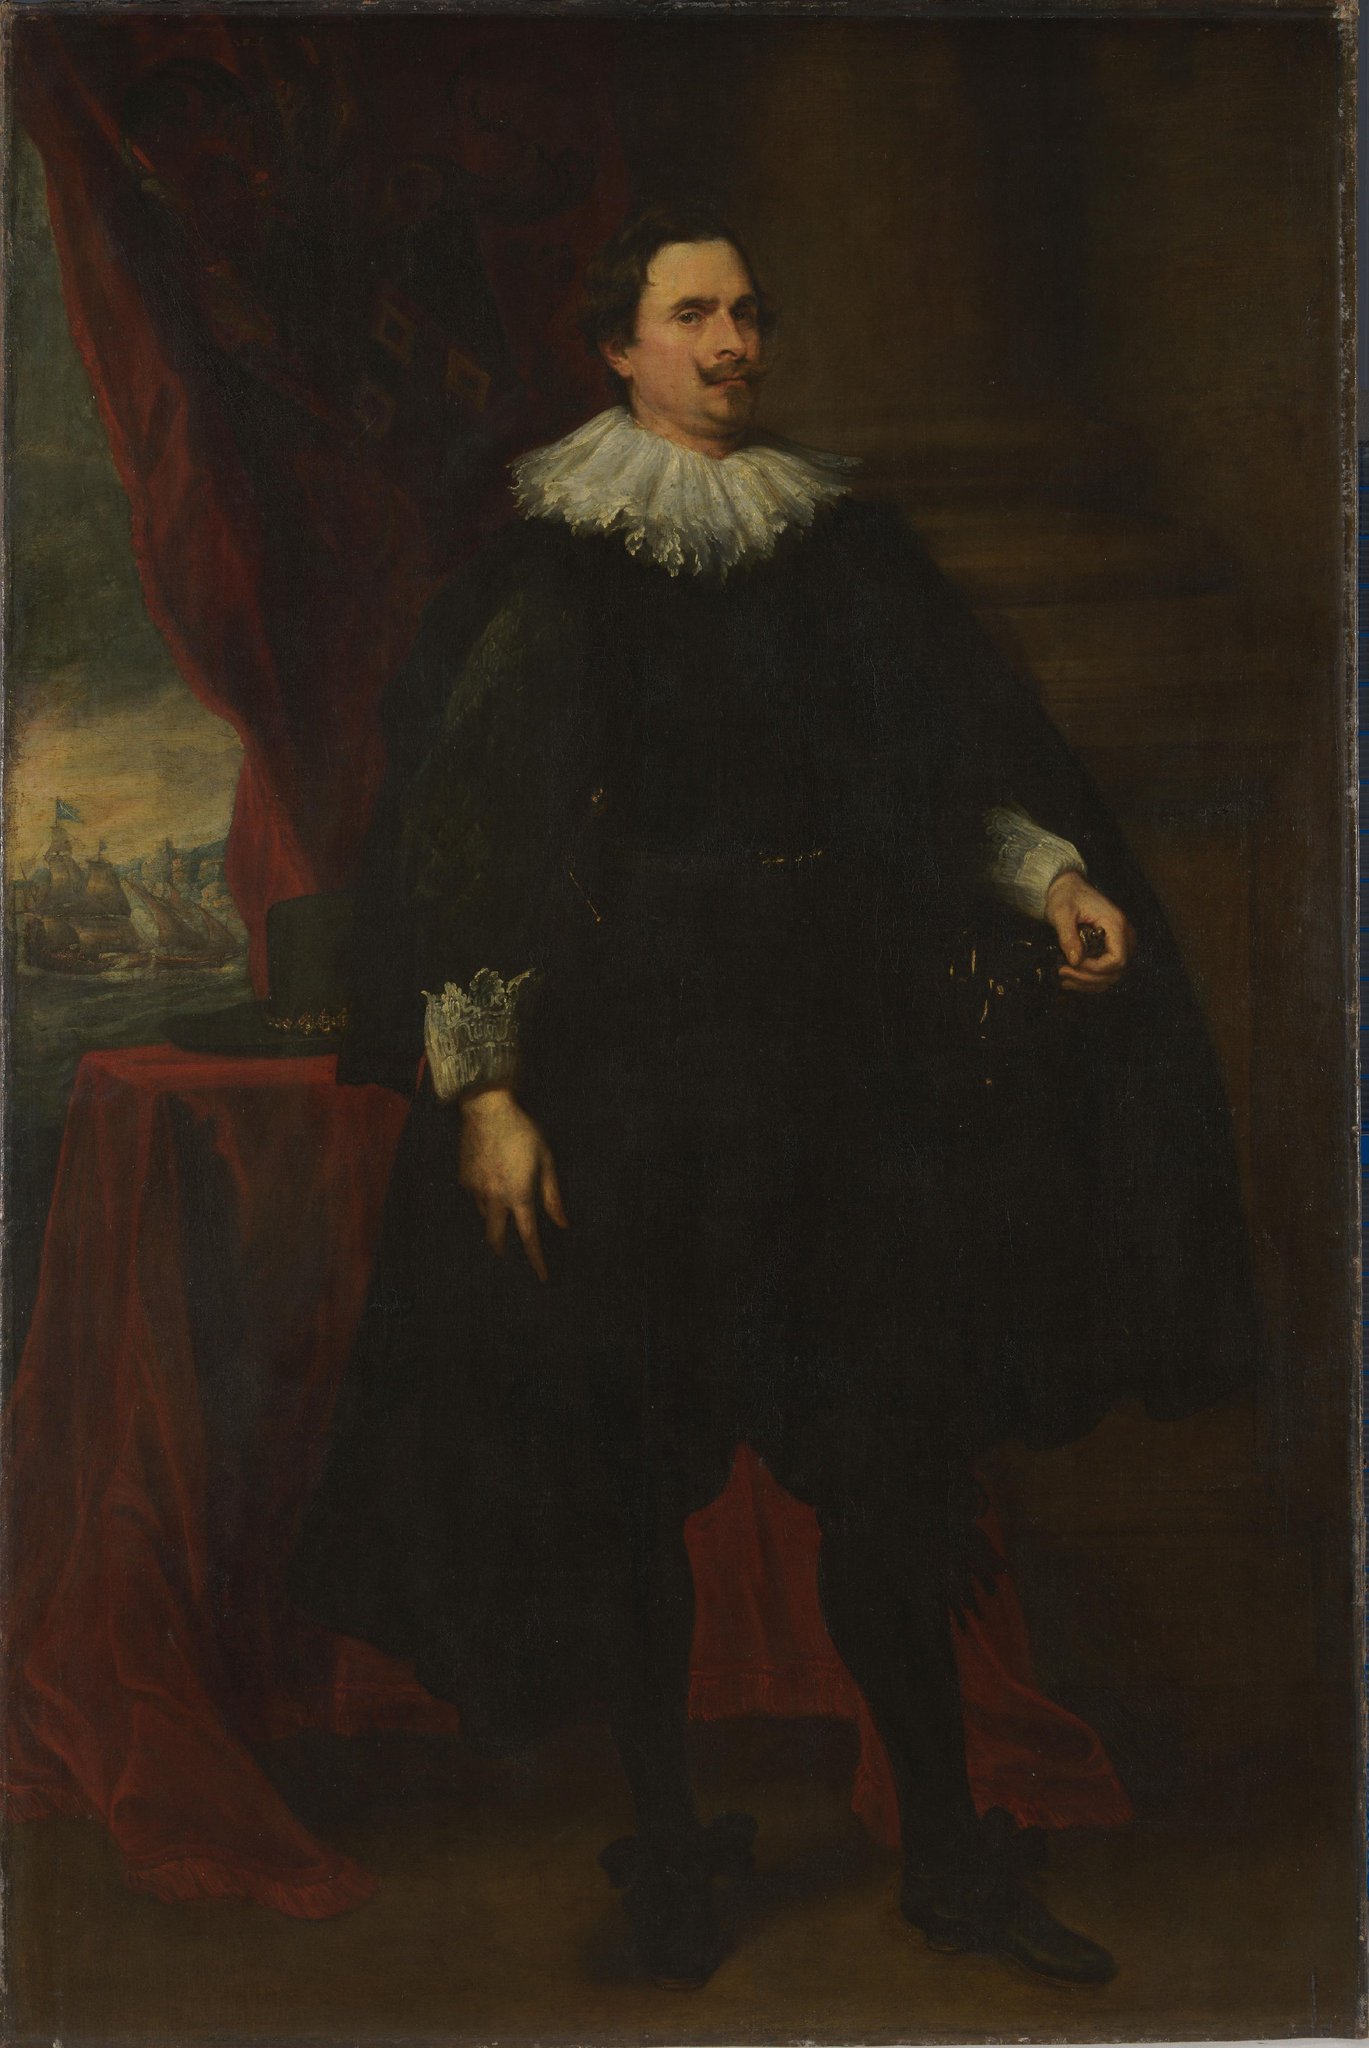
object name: painting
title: Portrait of a Male Member of the Van der Borcht Family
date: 1635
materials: canvas, oil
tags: merchant, salesman, historical persons not known by name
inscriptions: coat of arms, indistinct, upper left, on the draped hanging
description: Portret van een man uit de familie van der Borght, misschien François van der Borght. Staande ten voeten uit voor een tafel waar zijn hoed op ligt. Rechts een zuil, links een doorkijk naar een zeeslag.